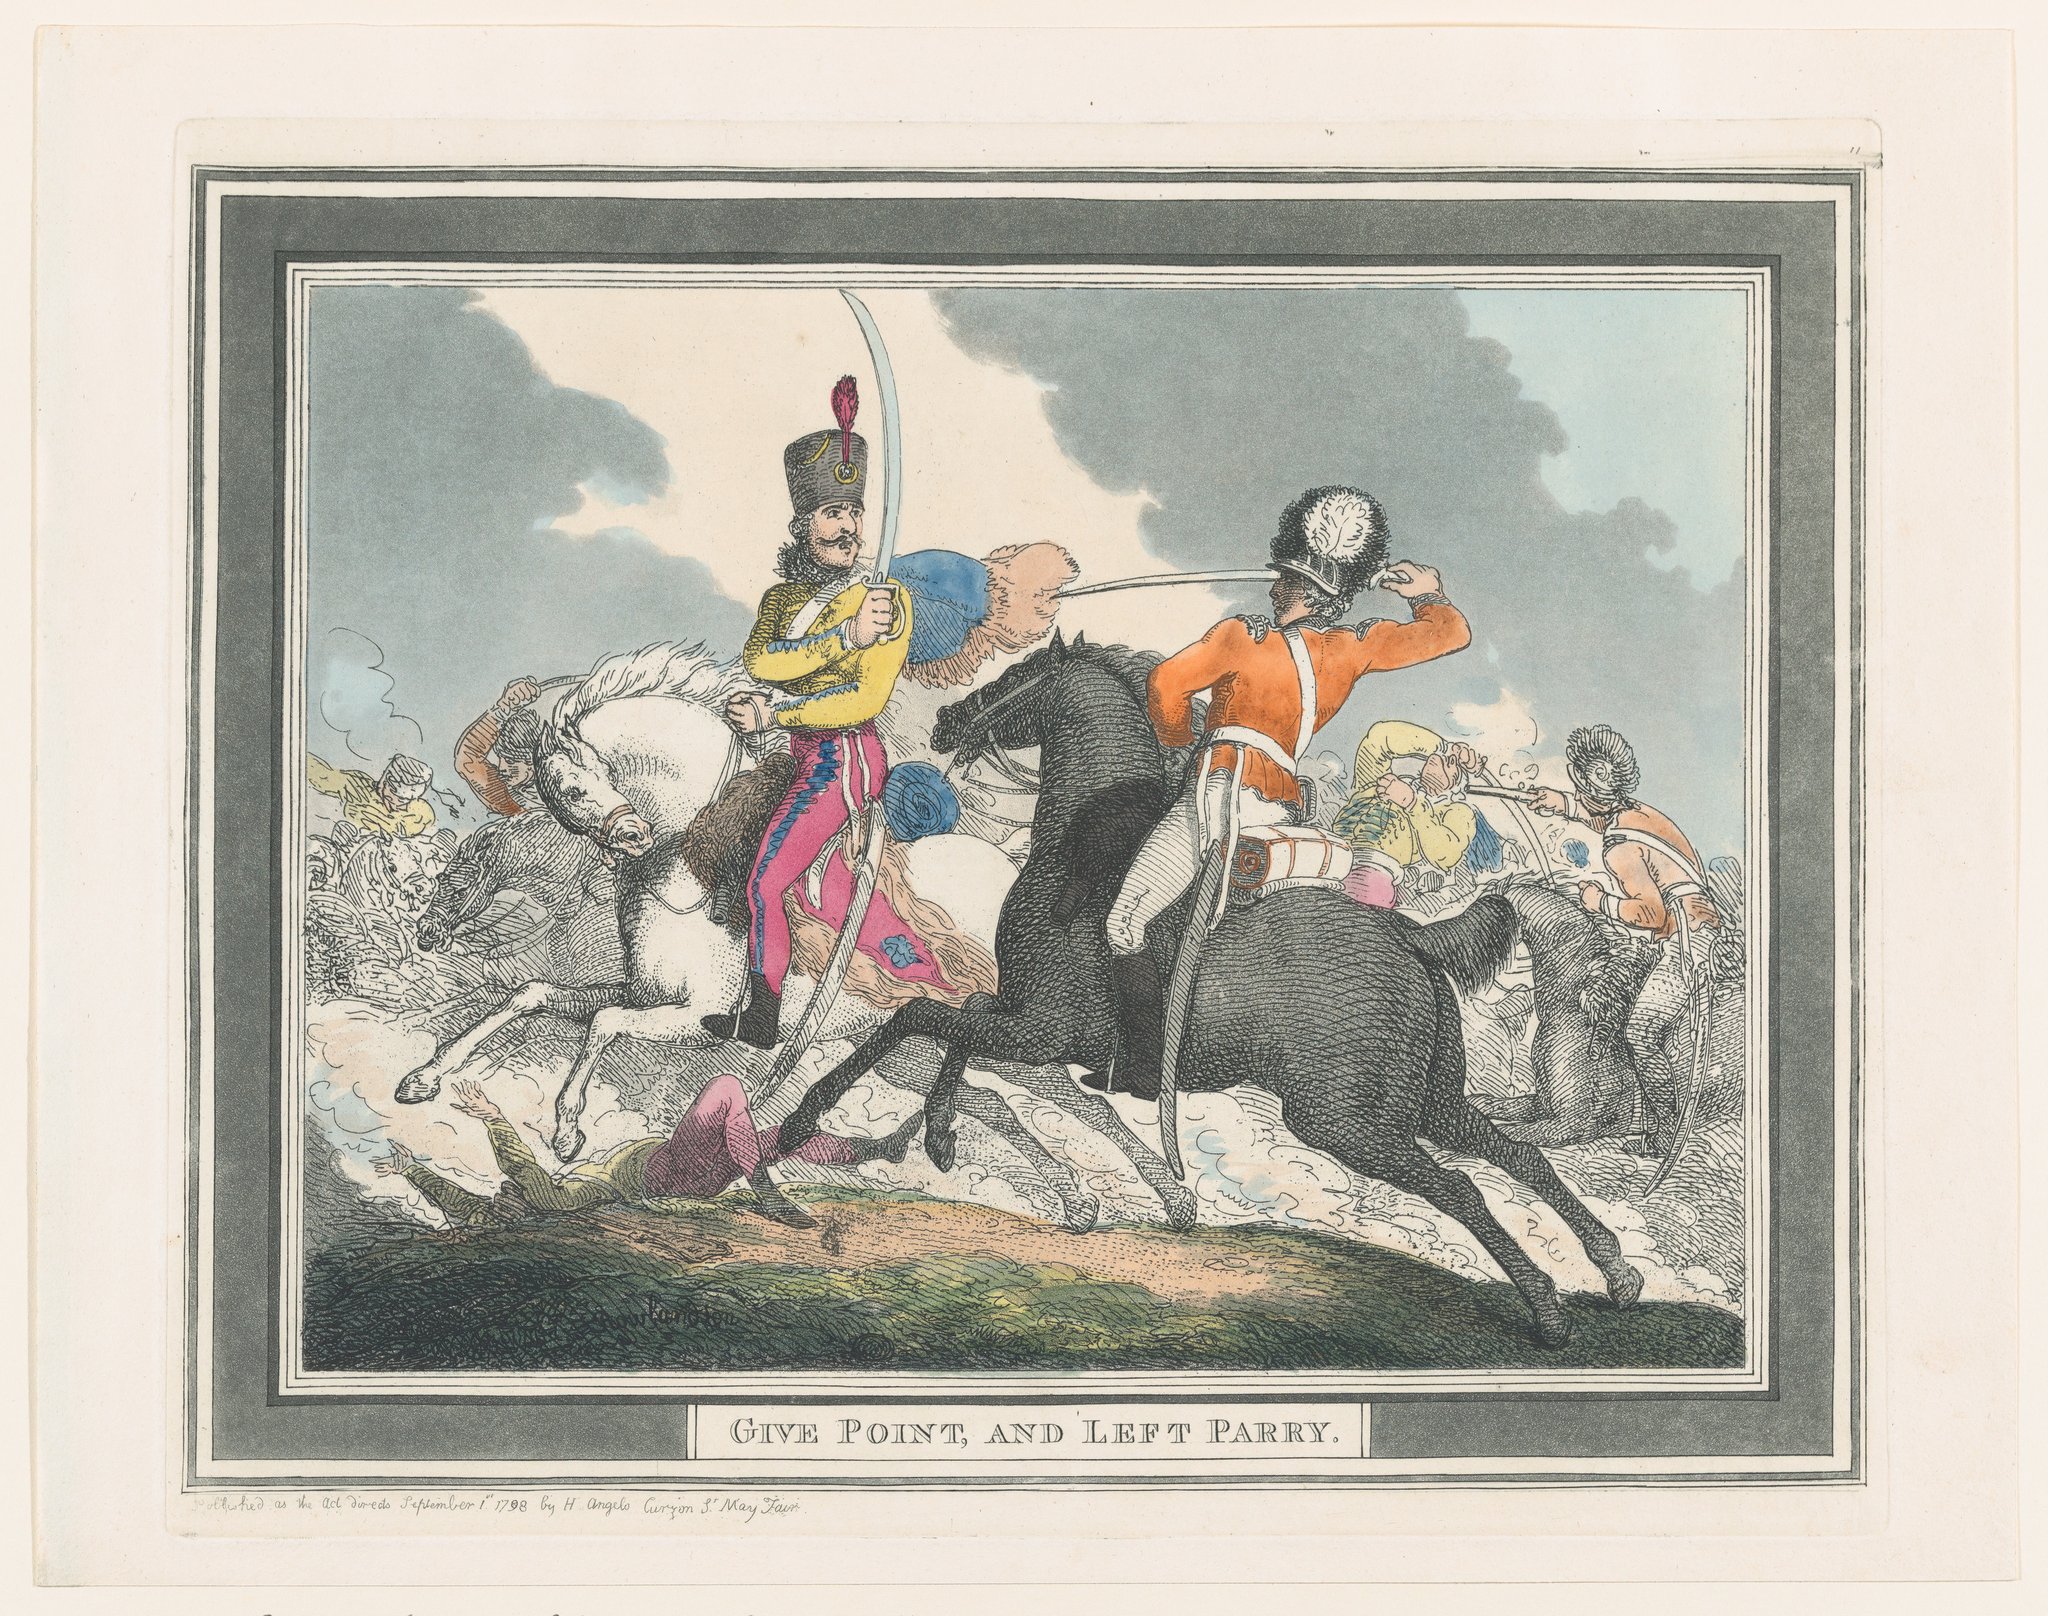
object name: print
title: Give Points and Left Parry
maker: thomas rowlandson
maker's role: artist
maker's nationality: british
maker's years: 1757-1827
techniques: aquatint, etching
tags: battles,soldiers,horses